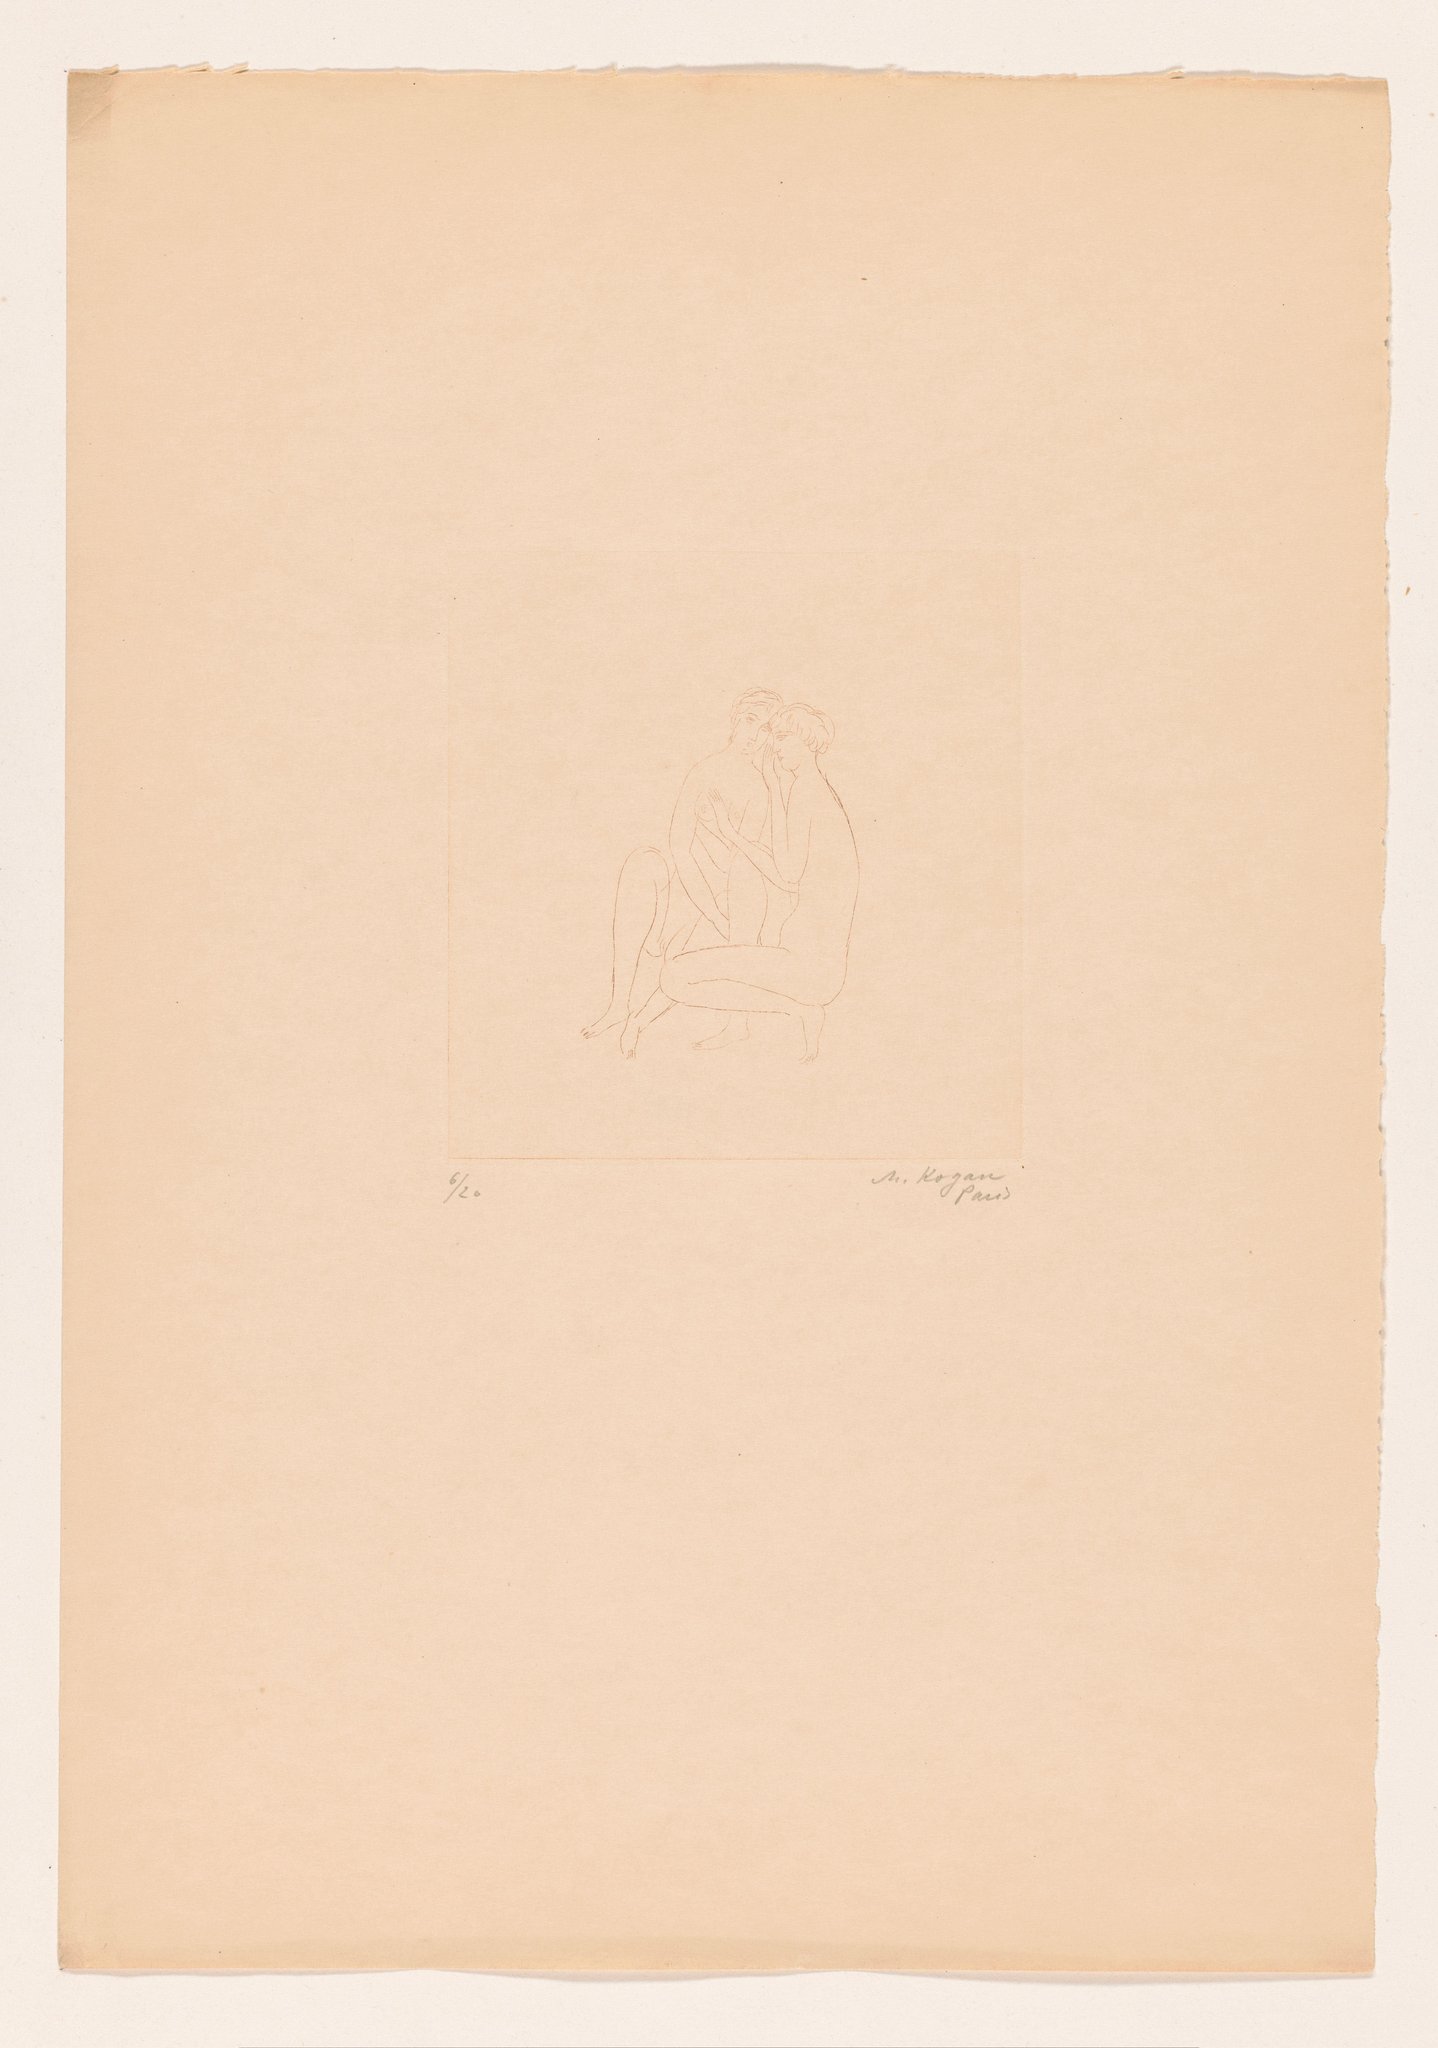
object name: print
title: Twee zittende naakte vrouwen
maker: moissej kogan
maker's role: print maker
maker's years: 1879-1943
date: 1889-1943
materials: paper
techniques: drypoint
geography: paris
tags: sitting figure - aa - female human figure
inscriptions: collector's mark: Lugt 2228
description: De linker vrouw van voren gezien, de rechter op haar zij.